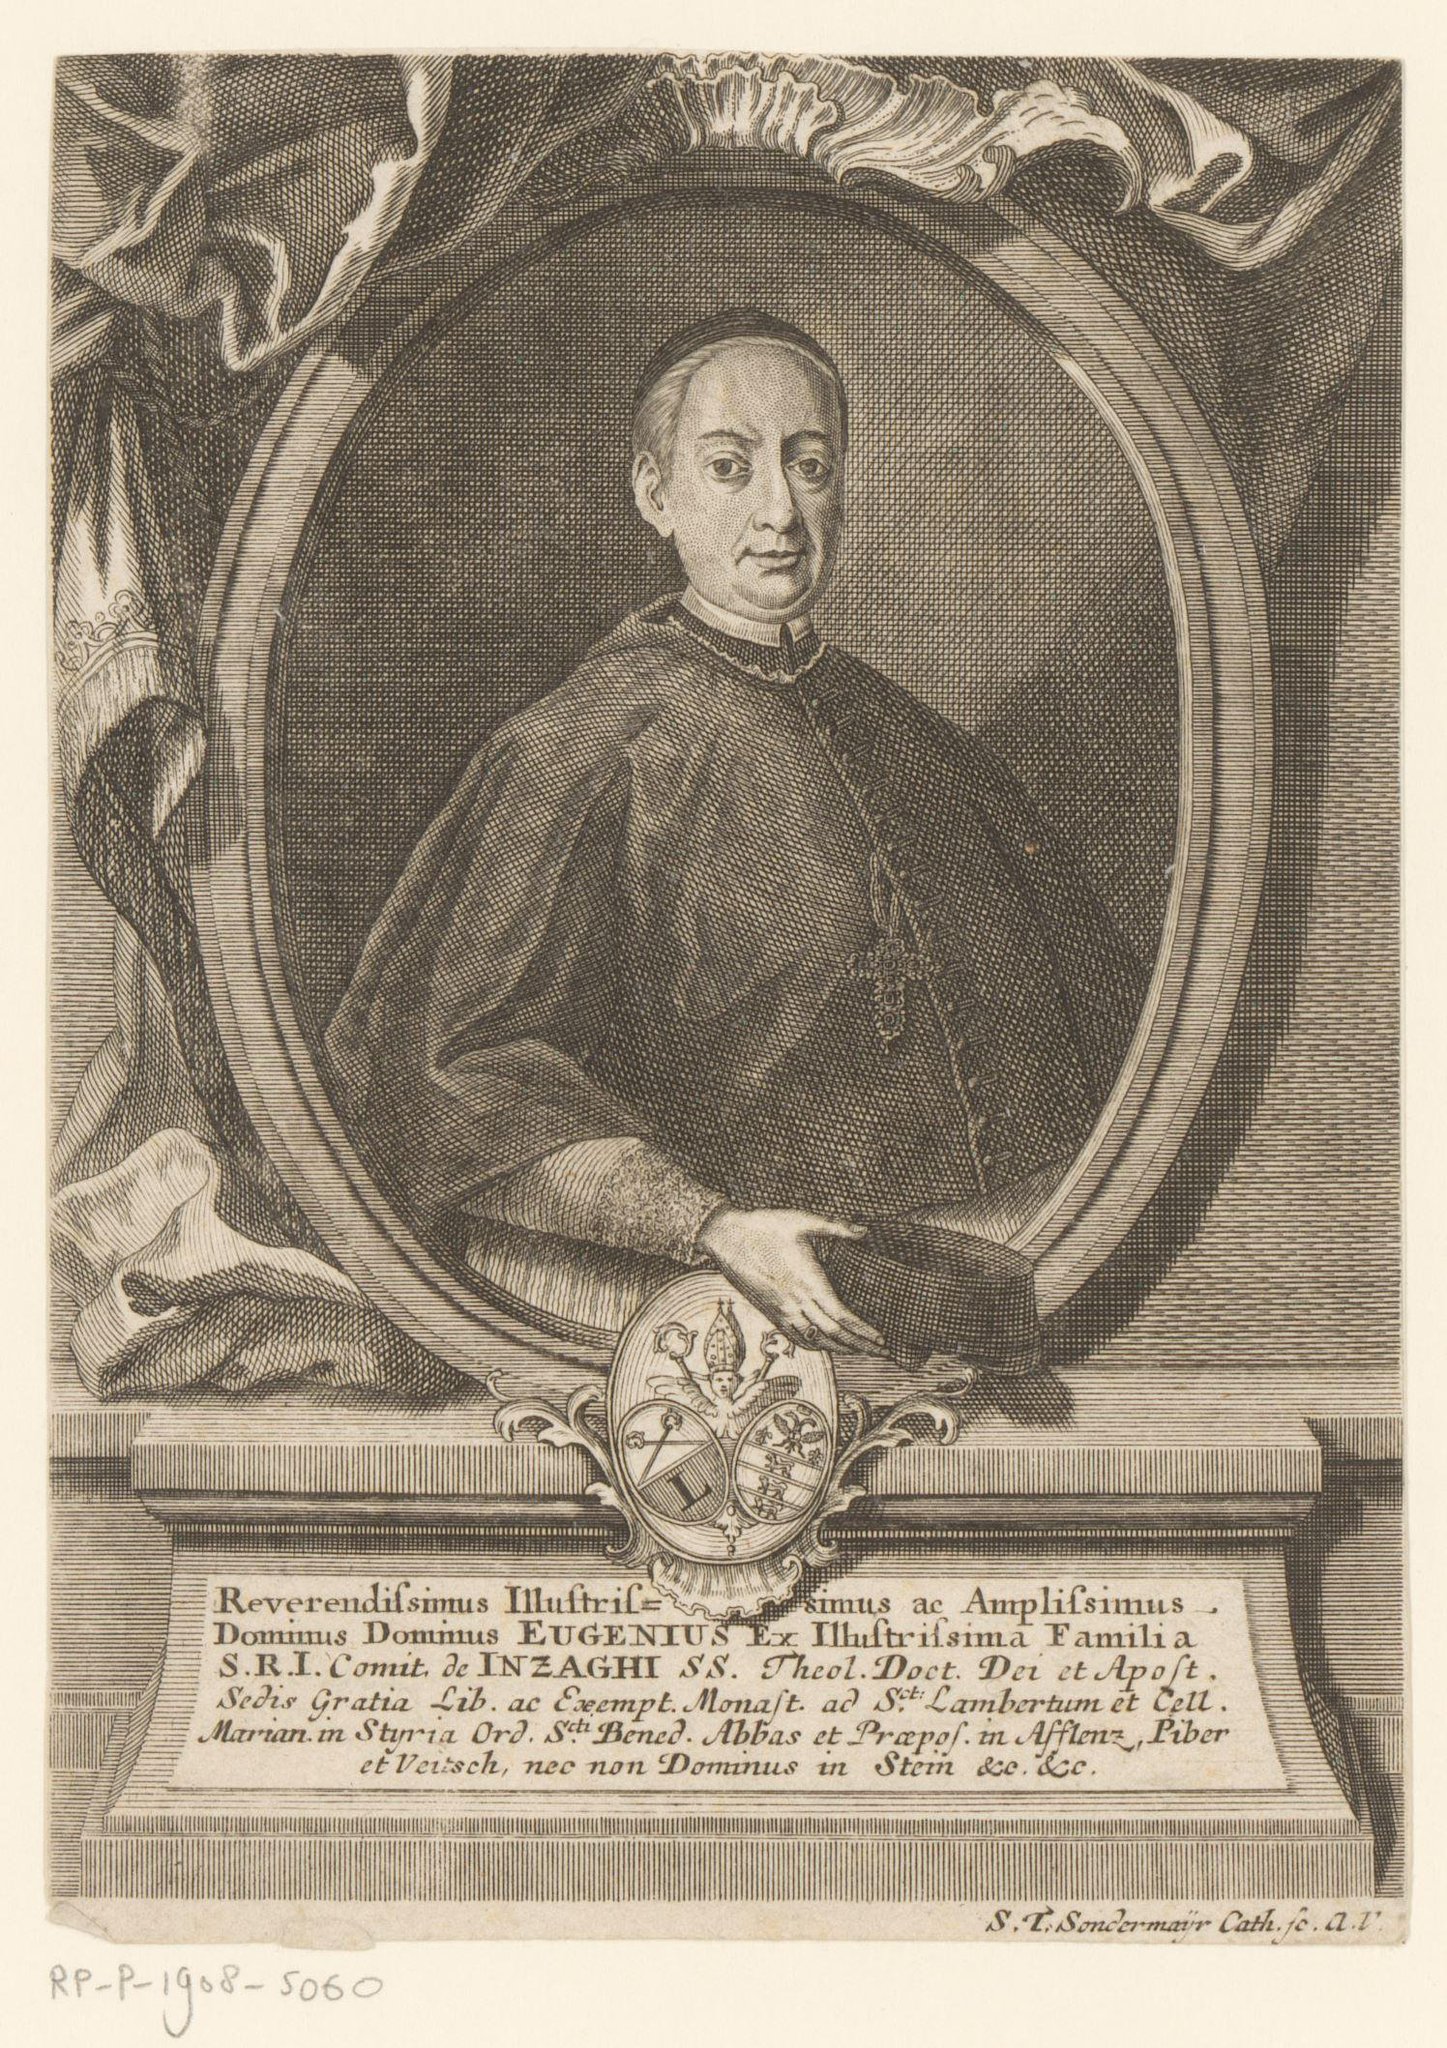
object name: print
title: Portret van Eugen, Reichsgraf von Inzaghi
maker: simon thaddäus sondermayr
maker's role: print maker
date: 1727-1751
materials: paper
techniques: engraving, etching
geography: augsburg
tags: austria, clergyman, historical persons, armorial bearing, heraldry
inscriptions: collector's mark: Lugt 2228